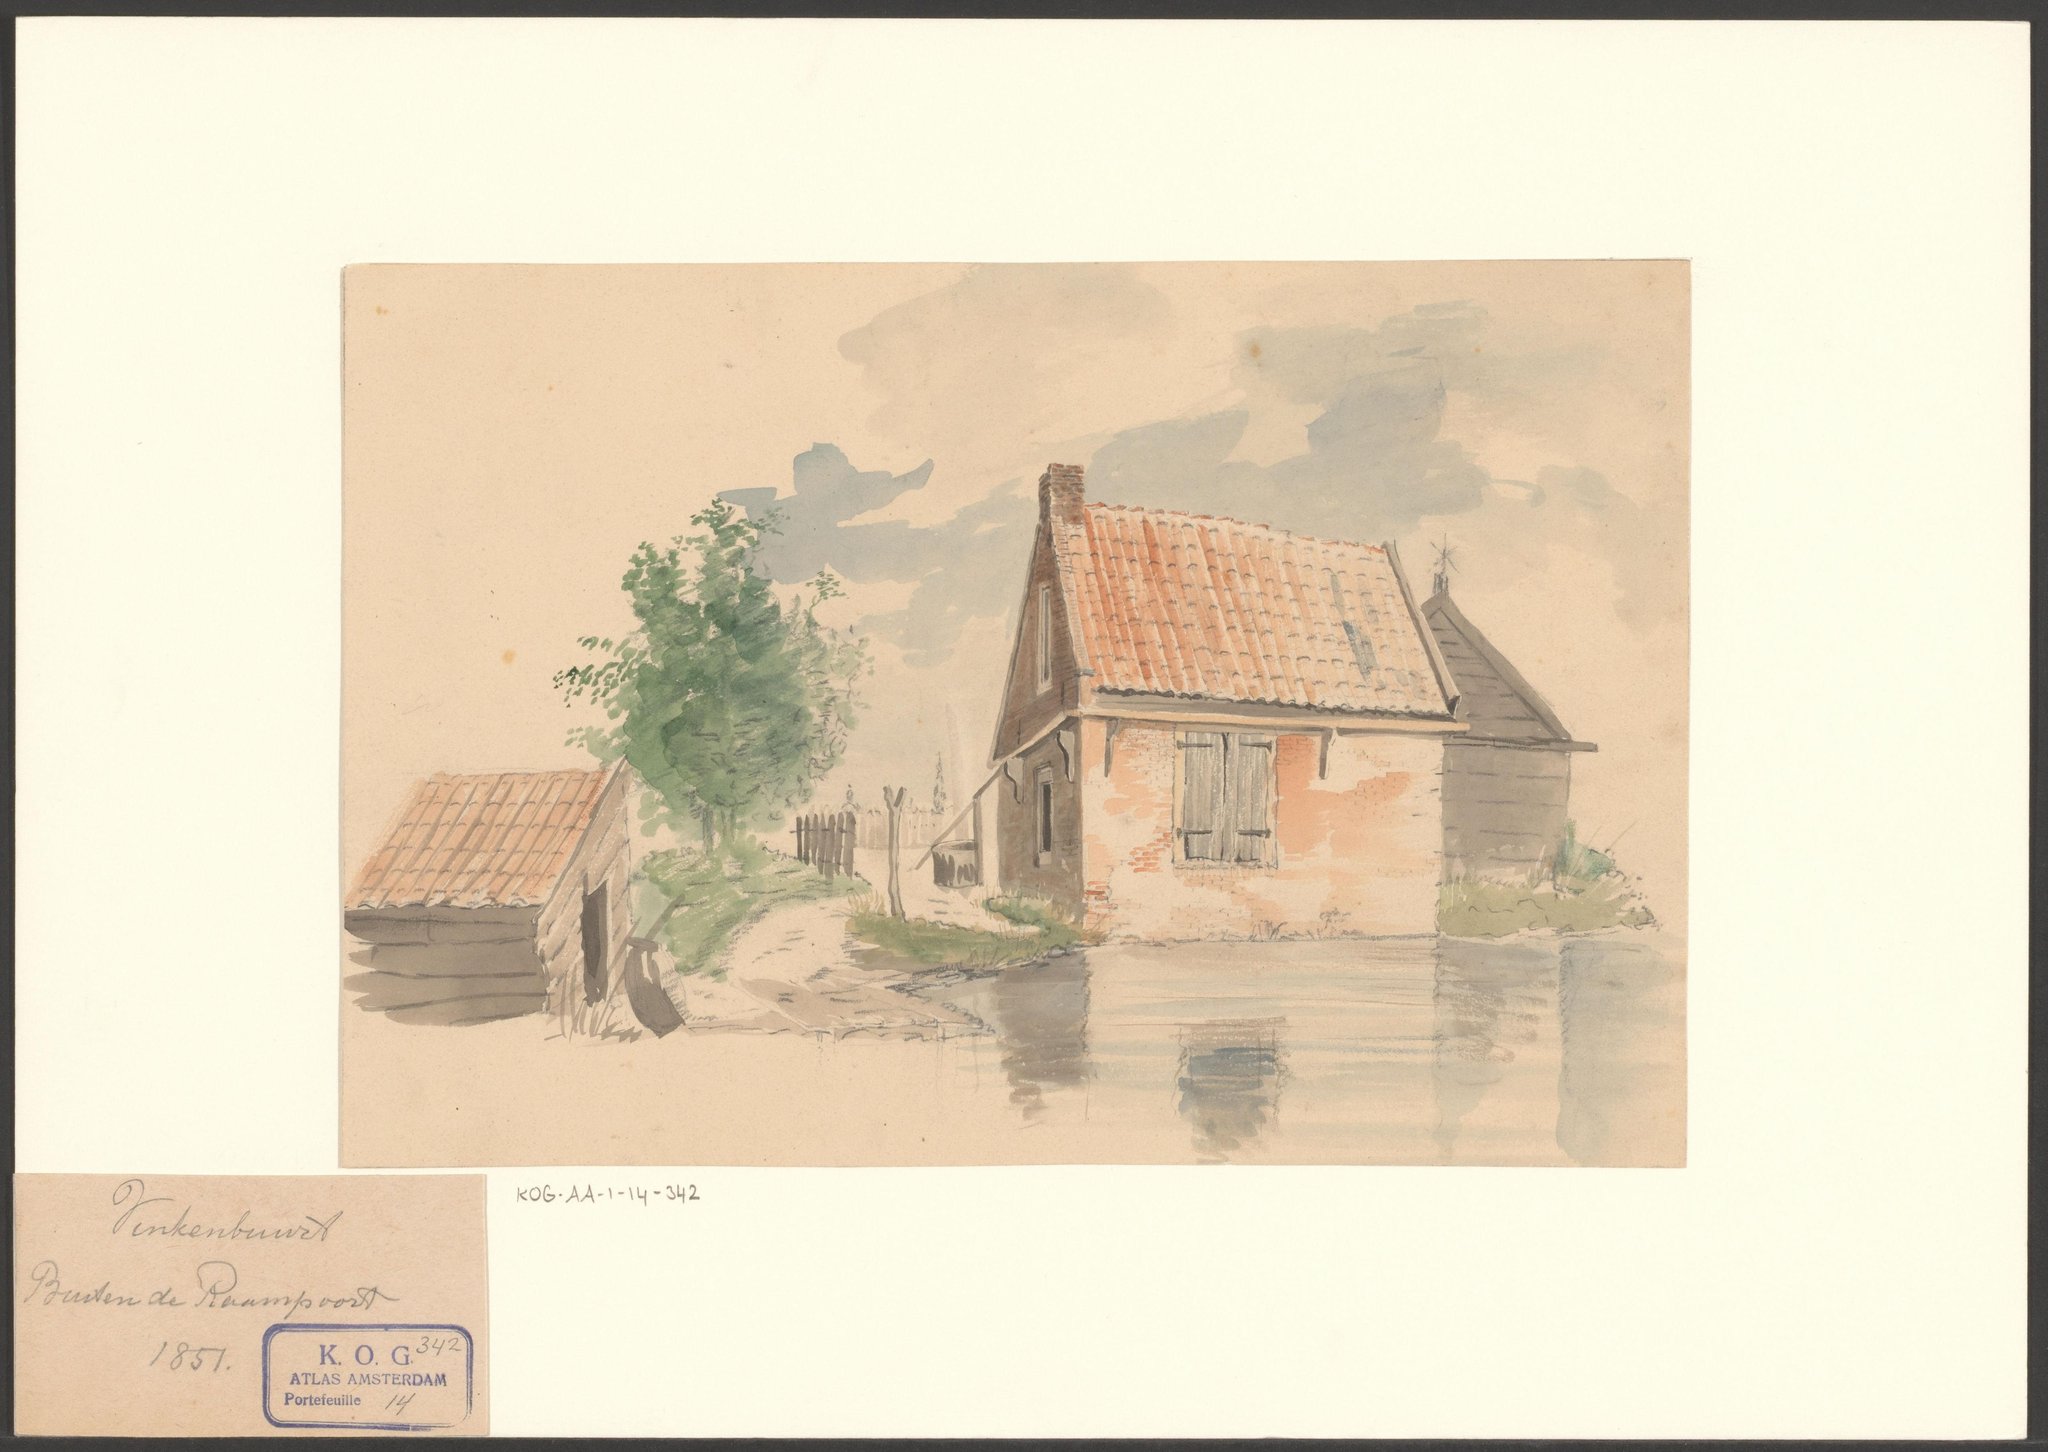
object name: drawing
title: Gezicht op de Vinkenbuurt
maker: johan george lodewijk rieke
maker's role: draughtsman, print maker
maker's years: 1817-1898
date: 1851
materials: paper, pencil, watercolor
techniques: brush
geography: amsterdam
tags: city-view in general; 'veduta', canal, the usual house or row of houses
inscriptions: inscription: ‘Port. 14-342’, collector's mark: ‘14’ Lugt 1641b, signature, date and inscription: ‘Vinkenbuurt. / Buiten de Raampoort / 1851 J.G.L. Rieke’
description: Onderwerpsrubriek binnen de Atlas Amsterdam: Verhulststraat (Johannes), Viaducten, Vierwindenstraat, Vinkenbuurt, Vinkenpad, Vinkenstraat, Vischsteeg, Vliegendesteeg, Voetboogstraat, Volewijk, Vondelstraat, Voorburgwal (N.Z.).